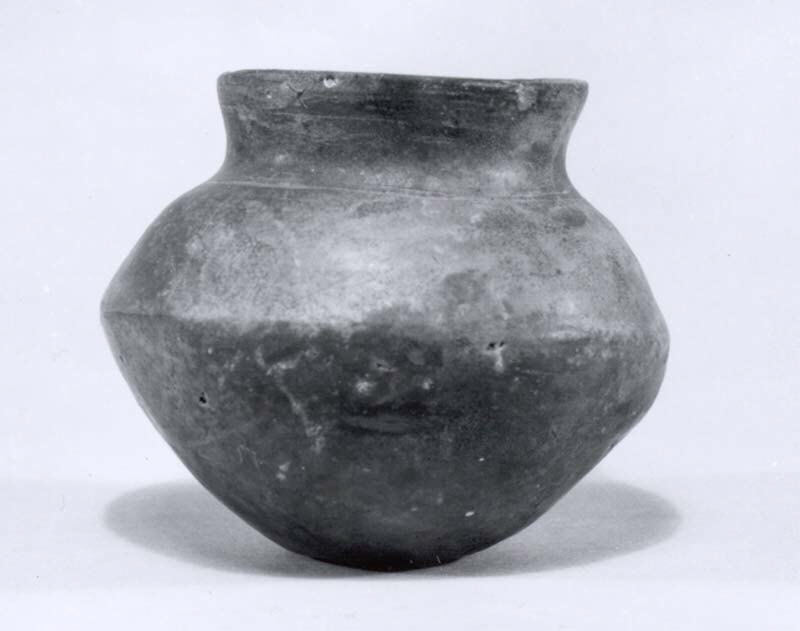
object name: jar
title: Miniature jar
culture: iranian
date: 1700-1600 BCE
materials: ceramic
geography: iran